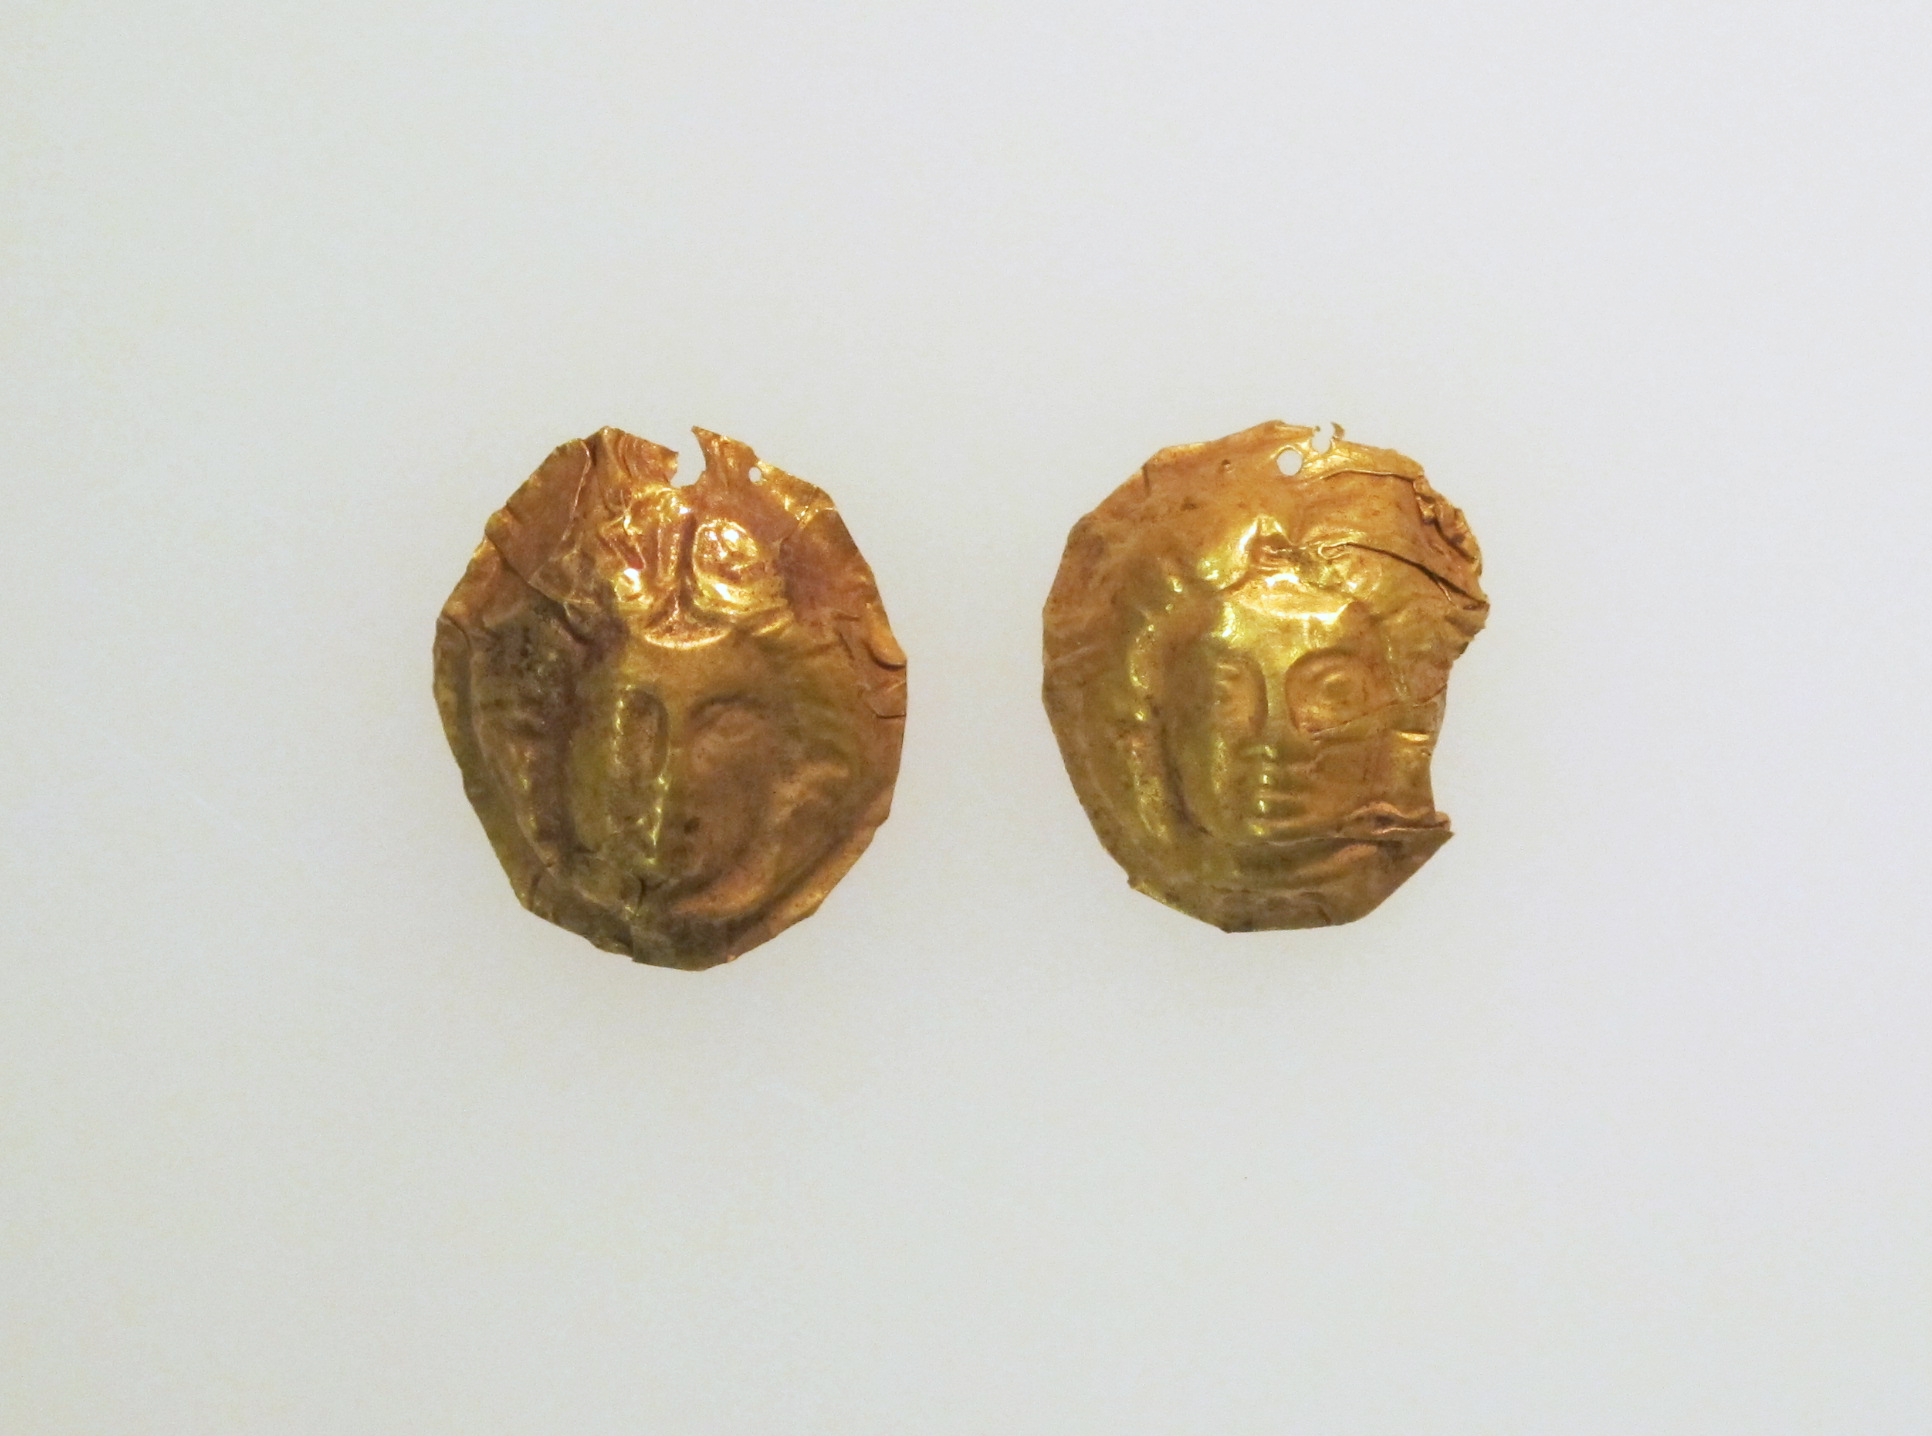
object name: bead ornament, 2 female mask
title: Bead ornaments, 2 female masks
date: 7000 BCE-330 CE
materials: gold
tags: women